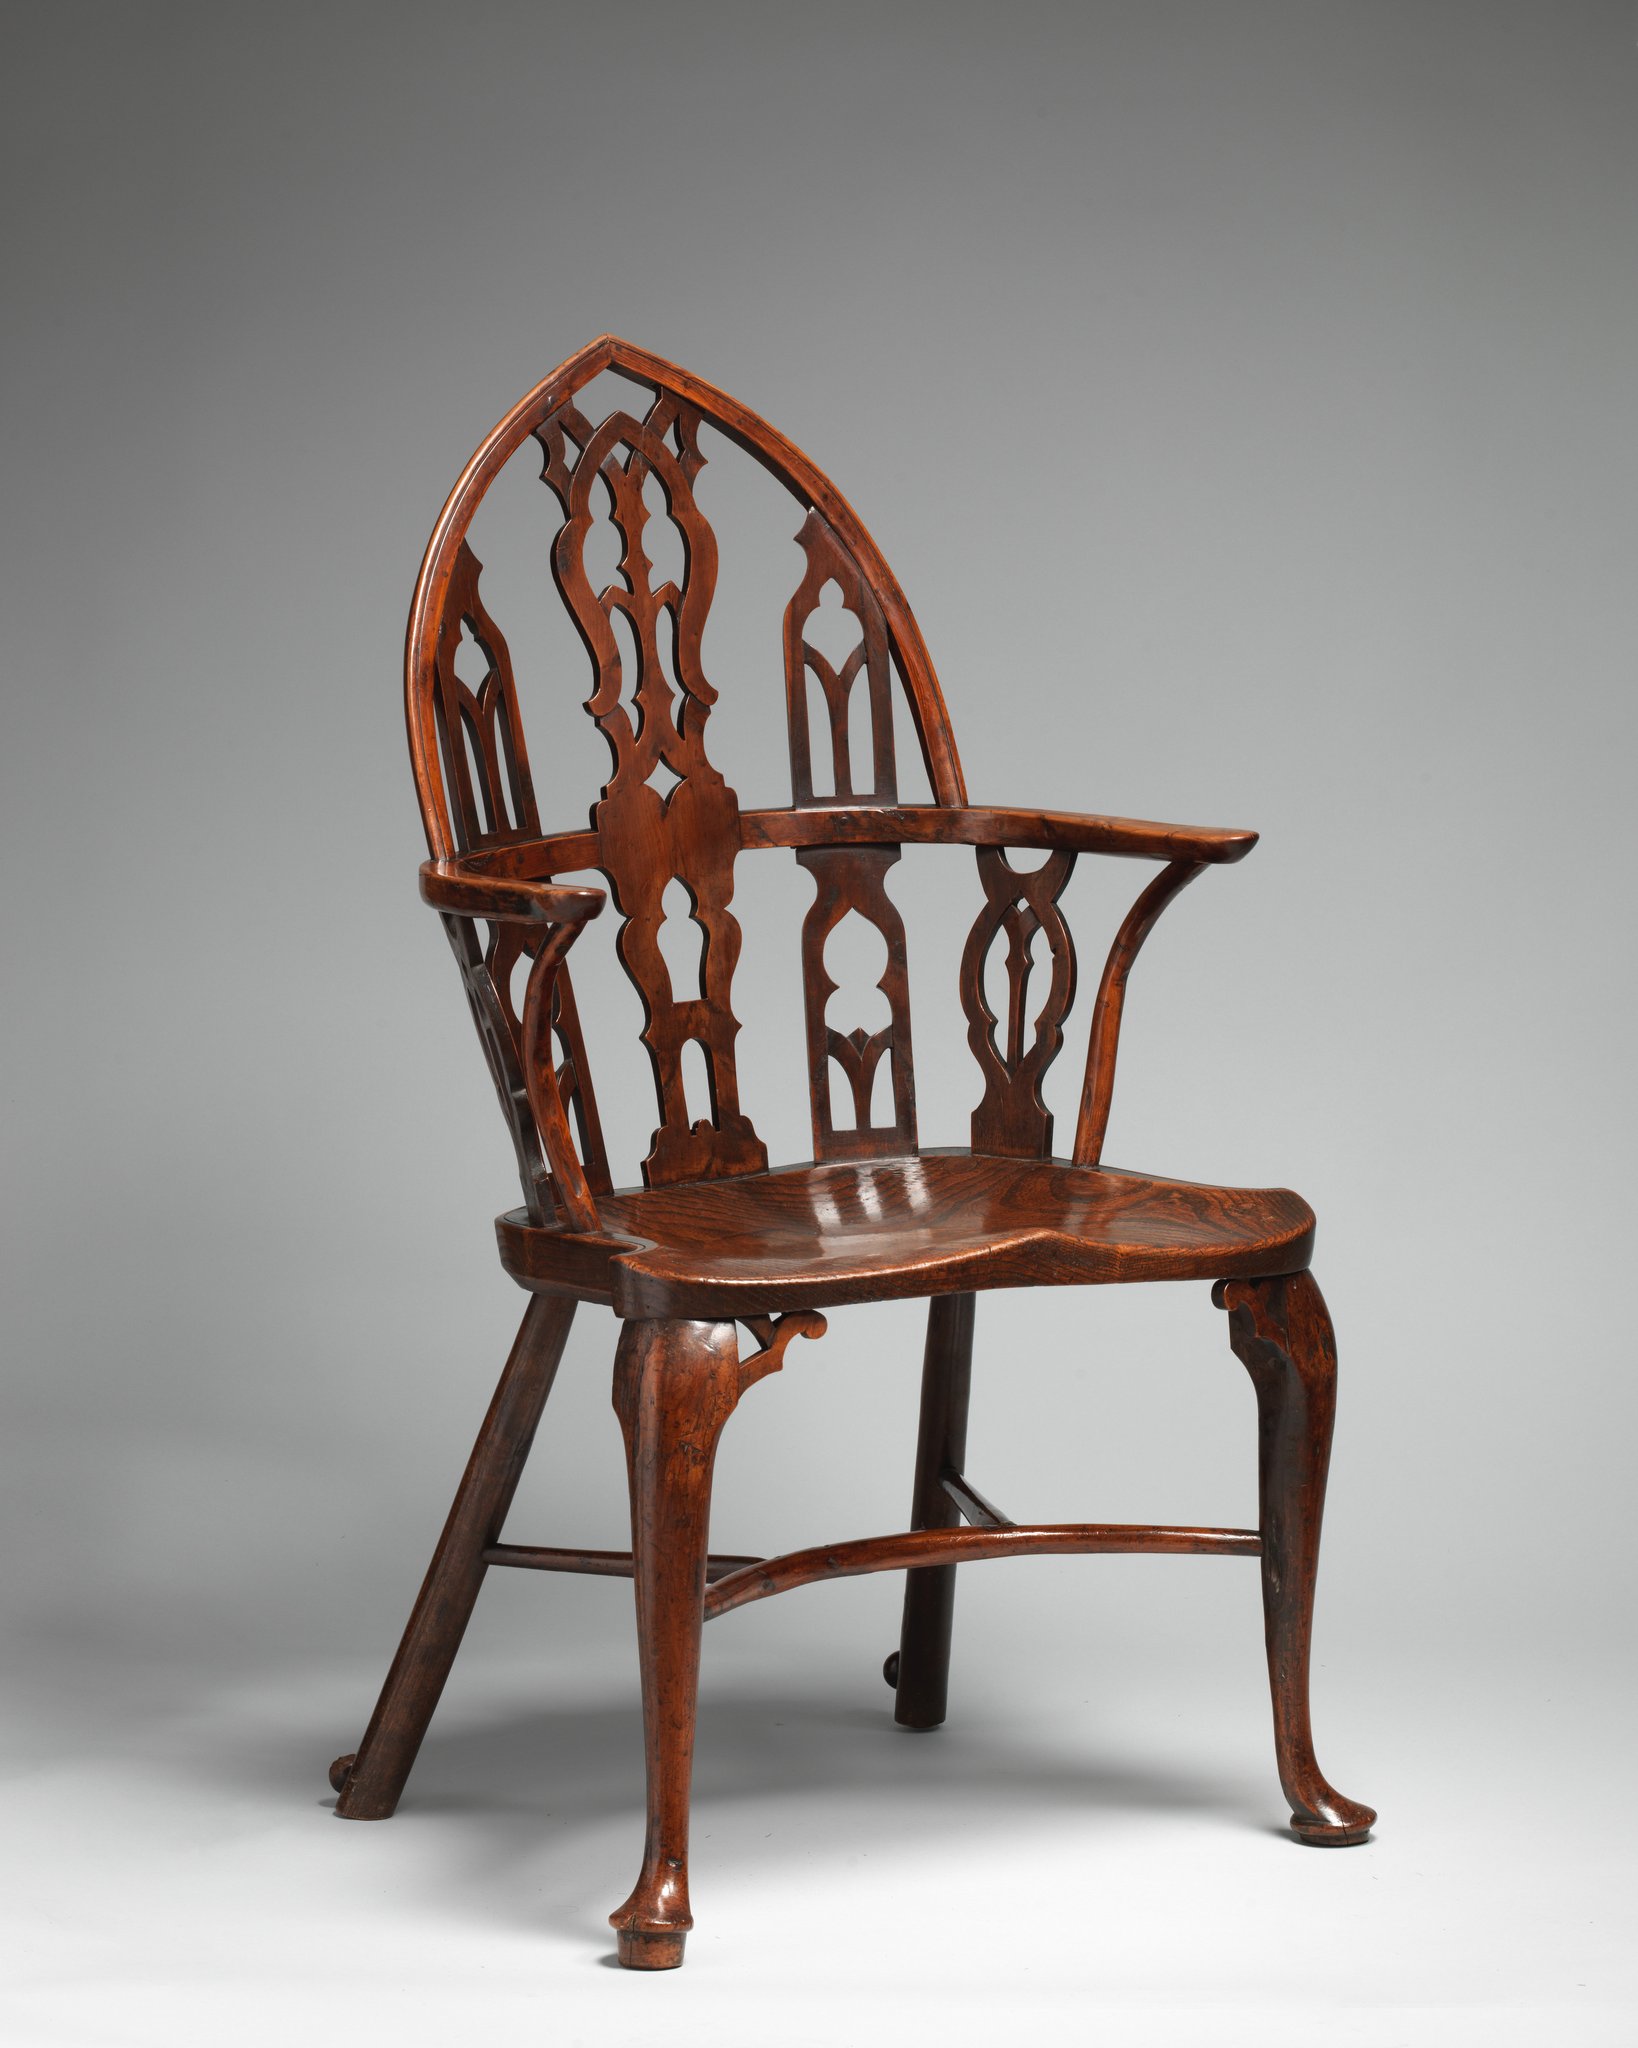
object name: armchair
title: Gothic Windsor armchair (one of a pair)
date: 1760-1769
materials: wood